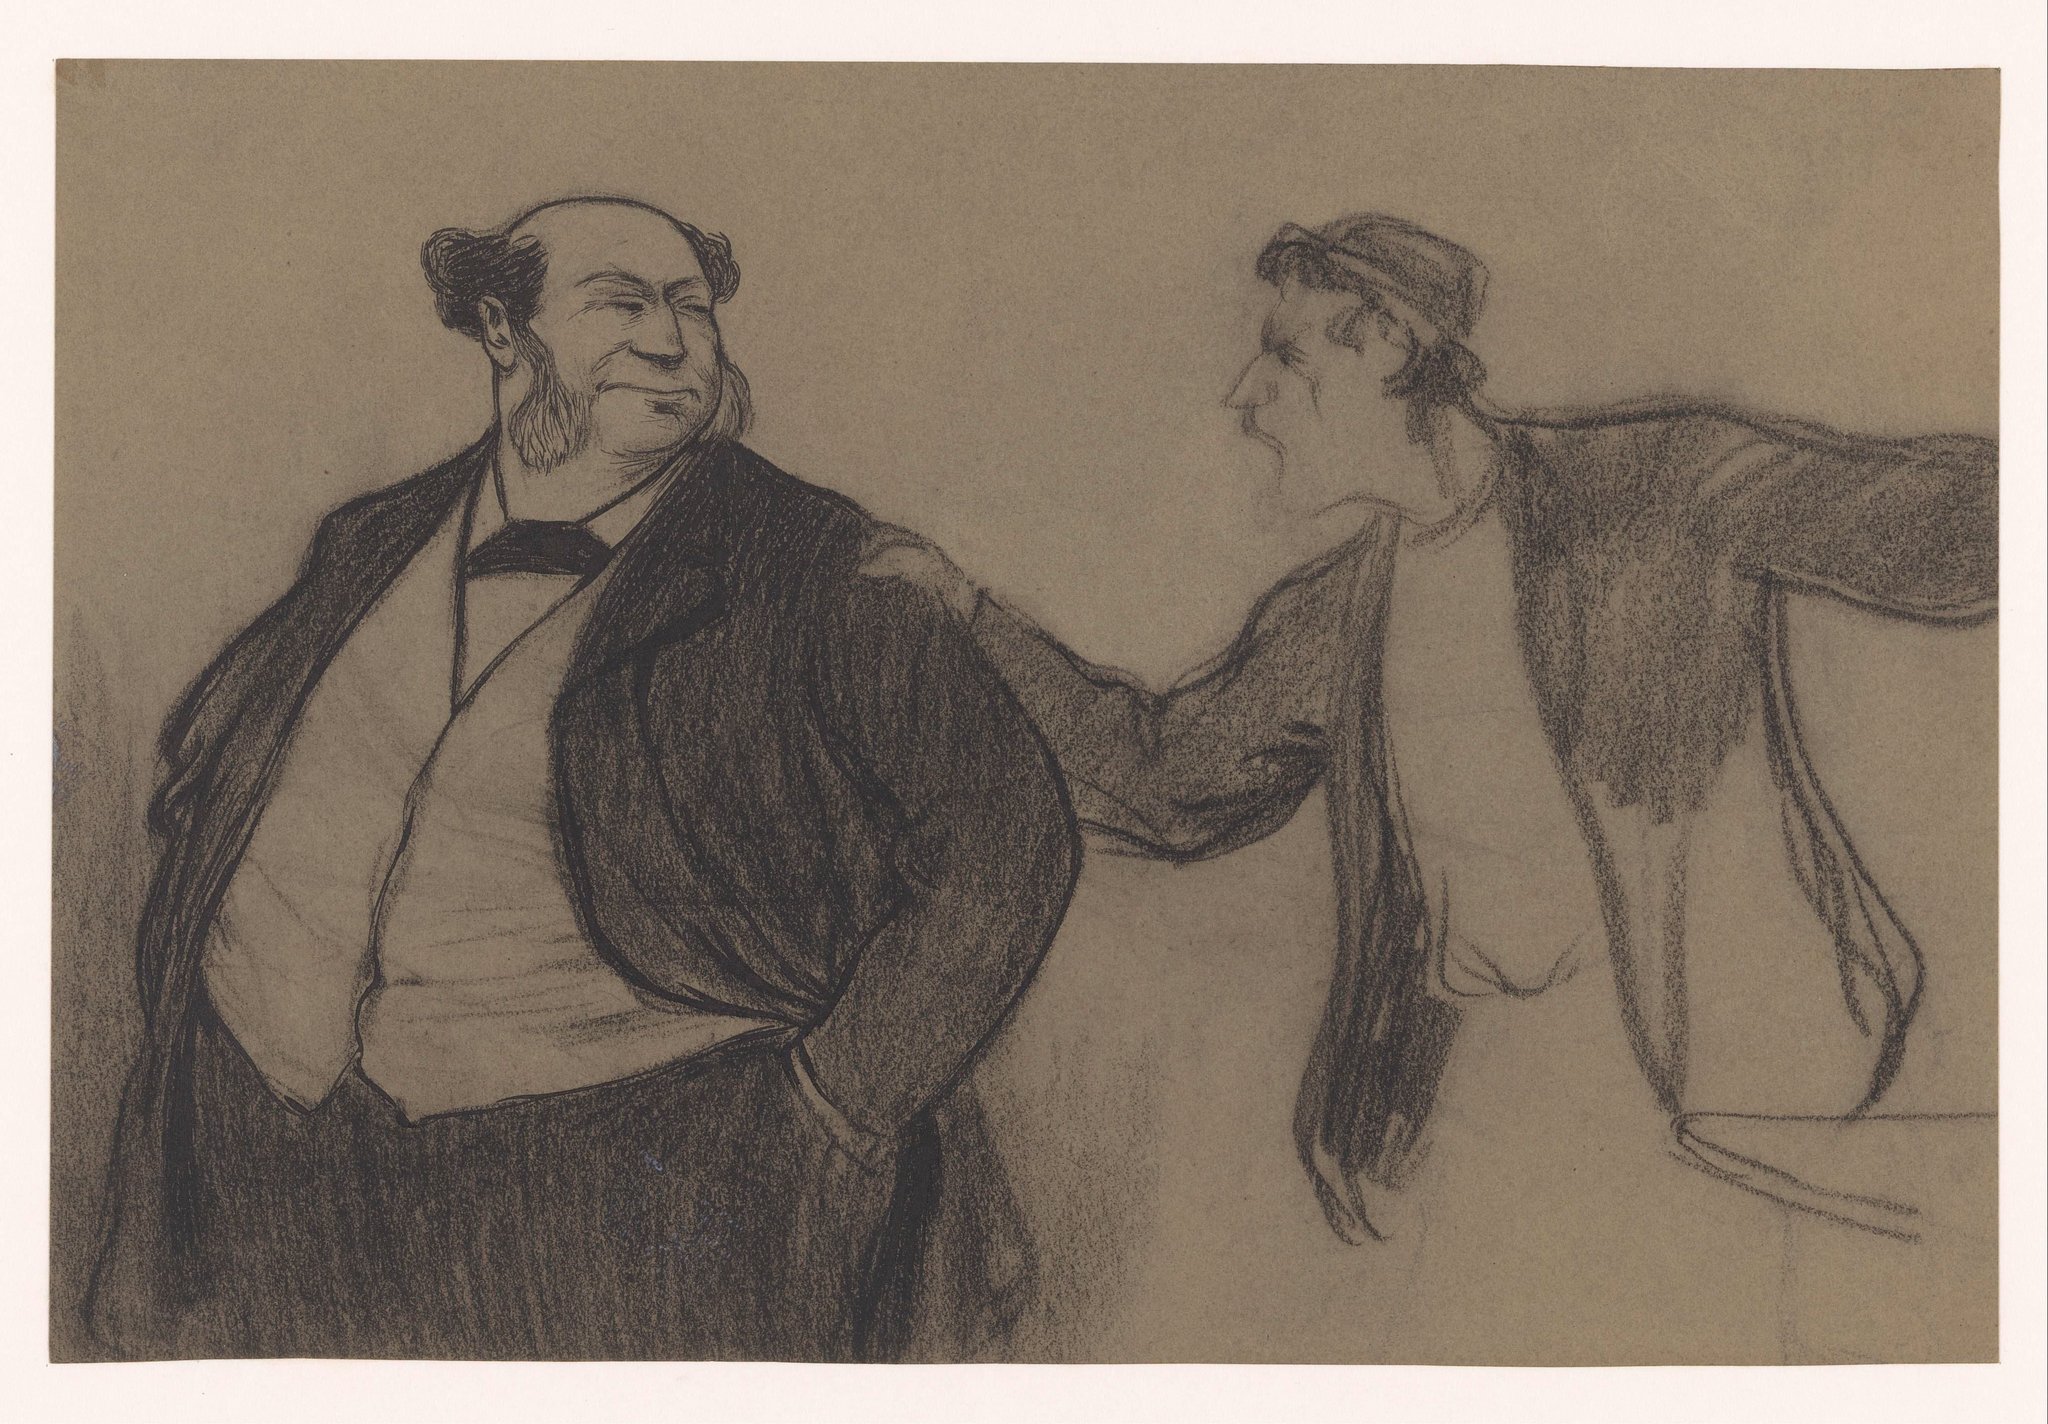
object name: drawing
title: Kapitalist en arbeider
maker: jan de waardt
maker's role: draughtsman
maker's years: 1871-1909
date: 1881-1899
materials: chalk, ink, paper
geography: netherlands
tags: director, boss (in modern industry), working class, labourers, netherlands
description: Twee mannen: stereotypen van kapitalist en arbeider. Links een dikke heer, glimlachend, de handen in de broekzakken. Rechts een slanker figuur, mond open, met pet. Hij legt zijn rechterhand op de linkerschouder van de ander, de linkerarm is geheven en verdwijnt rechts uit beeld.